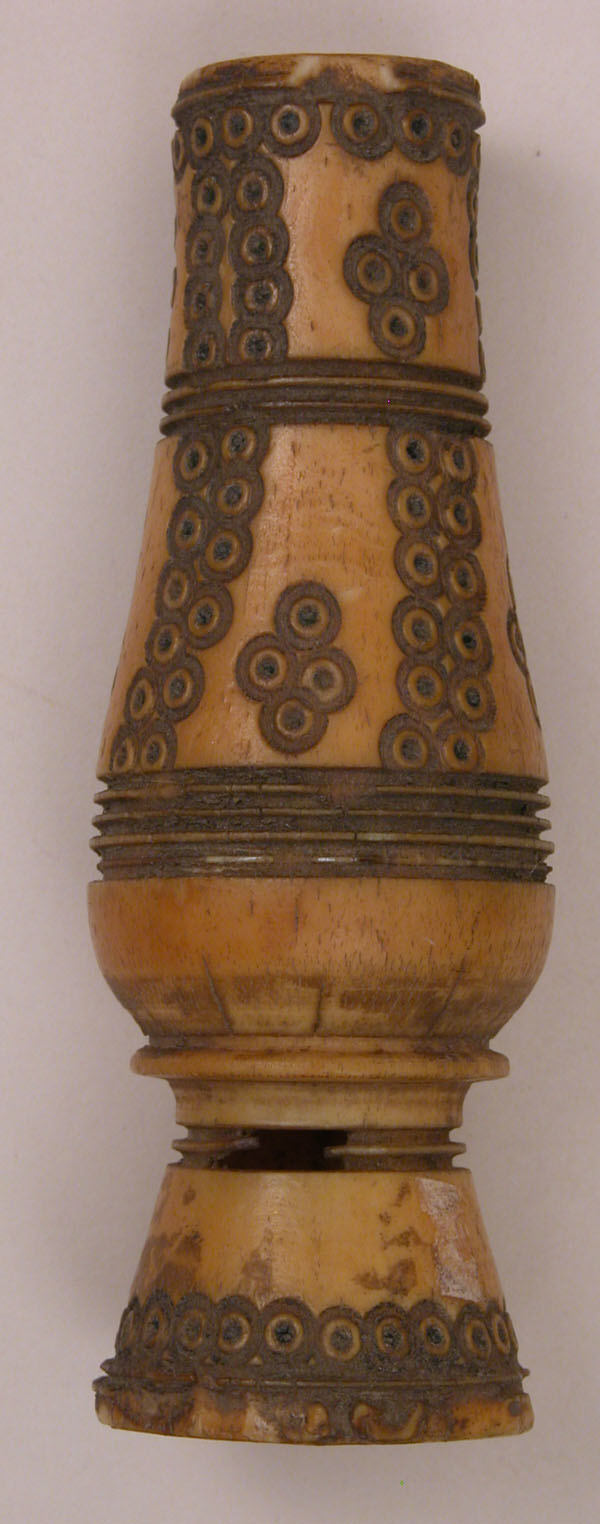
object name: handle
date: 801-1200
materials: bone, paint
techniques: incising, inlay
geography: egypt